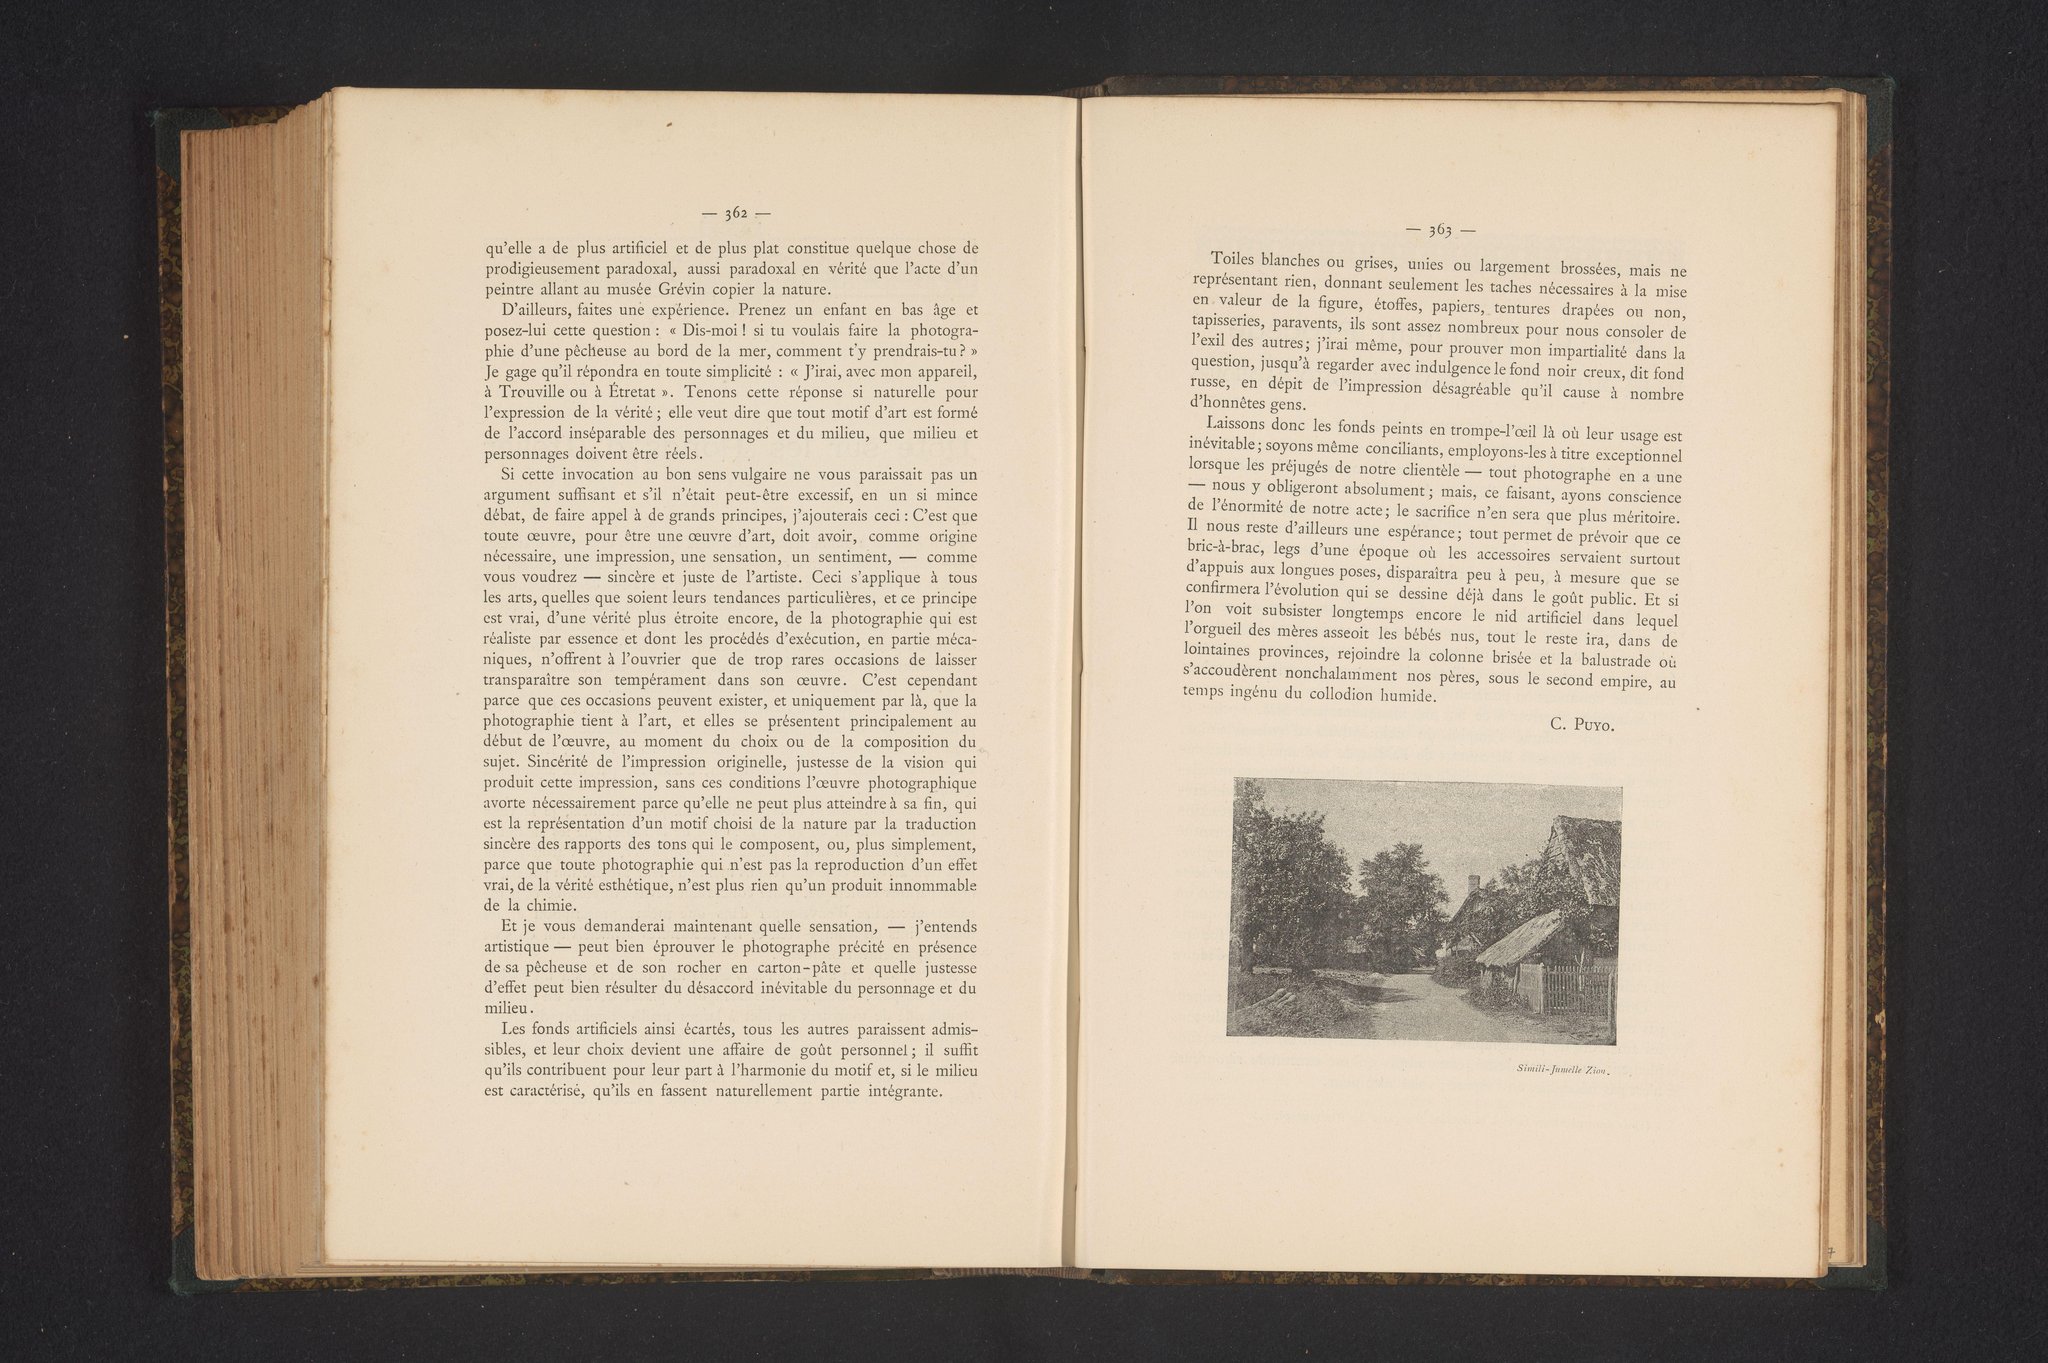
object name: photomechanical print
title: Gezicht op een paar huizen aan een landweg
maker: Anonymous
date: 1890-1895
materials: paper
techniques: photograph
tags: rural housing, e.g. country-house, villa, cottage, road, path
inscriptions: inscription: ‘Simili-Jumelle Zion.’